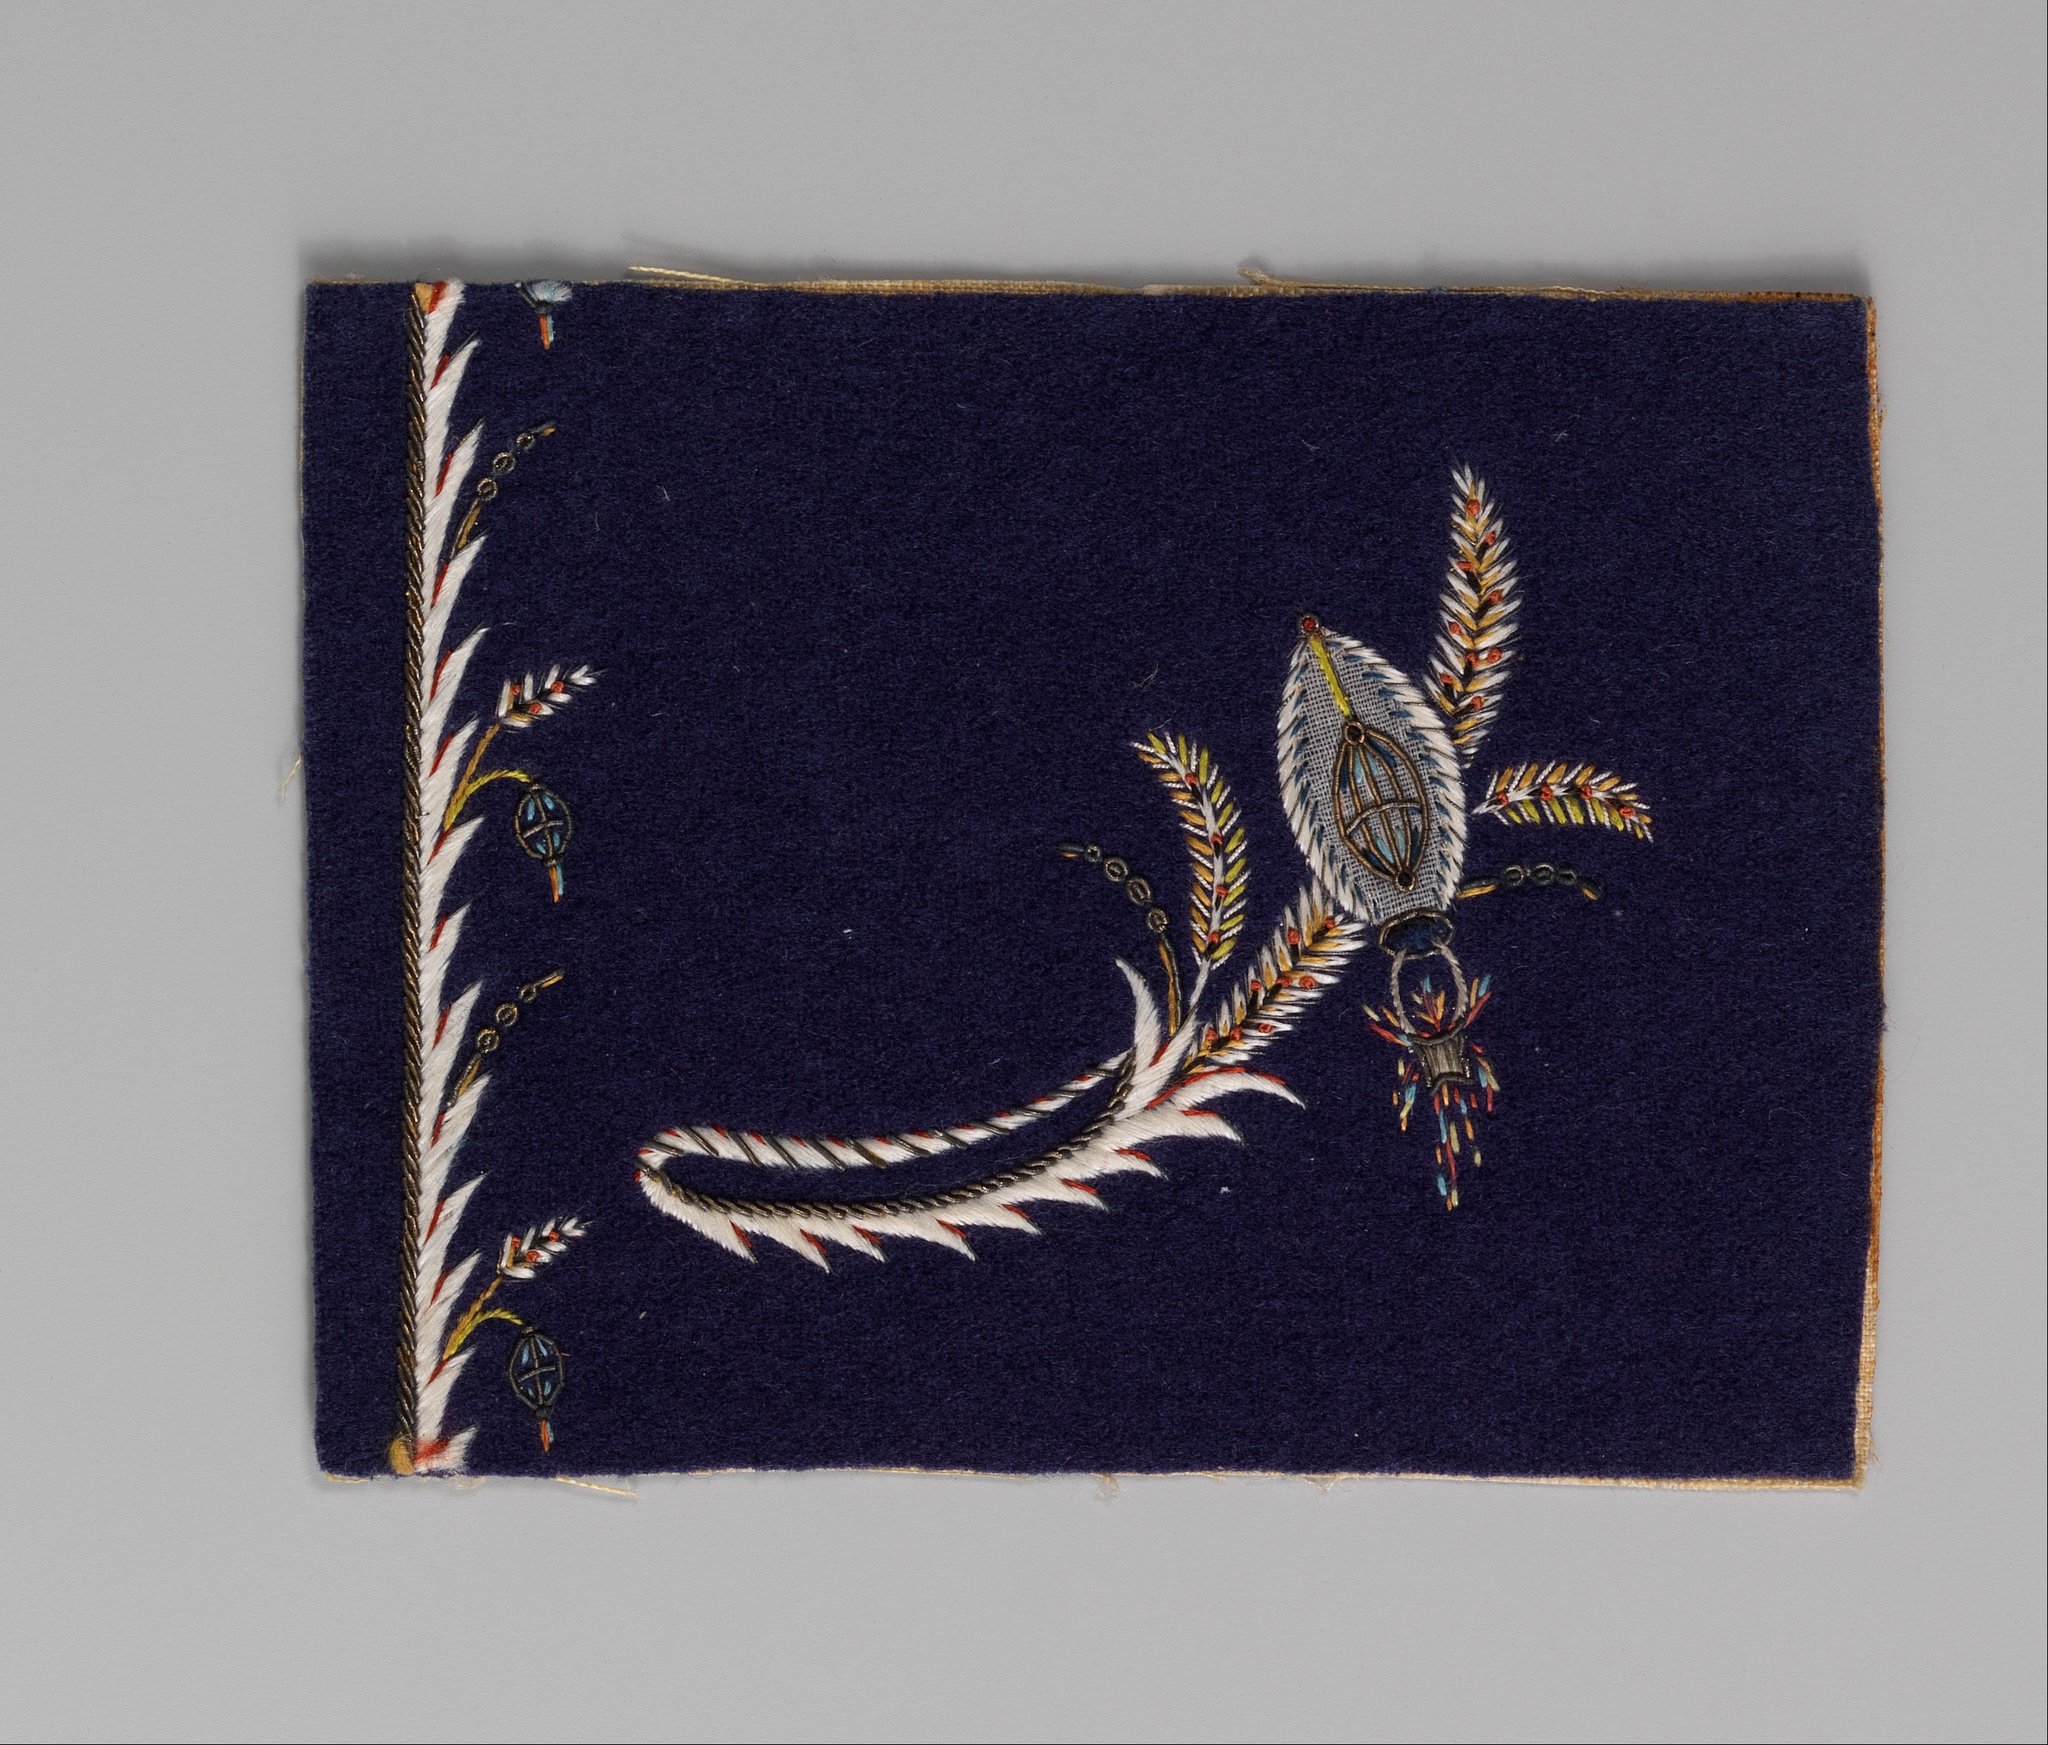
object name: sample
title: Embroidery sample for a man’s suit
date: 1785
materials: metal thread, silk, wool